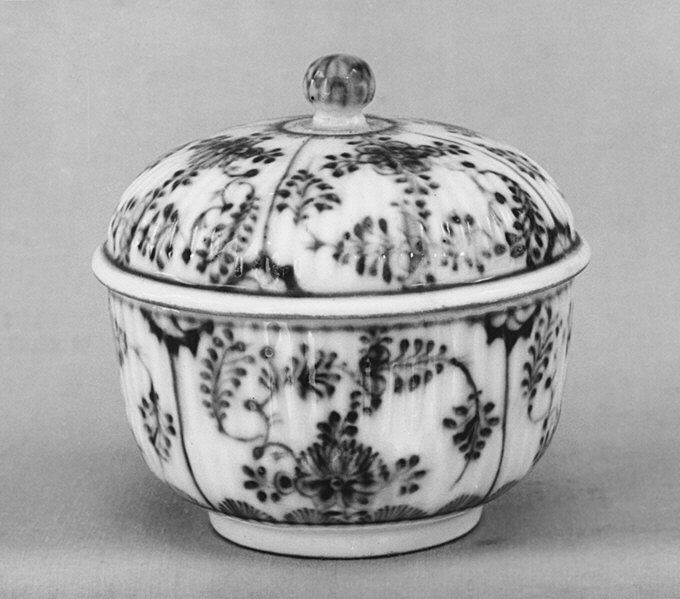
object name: bowl with cover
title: Bowl with cover (part of a set)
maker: meissen manufactory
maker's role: manufactory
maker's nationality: german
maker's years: 1710-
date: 1740-1750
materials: hard paste porcelain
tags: flowers